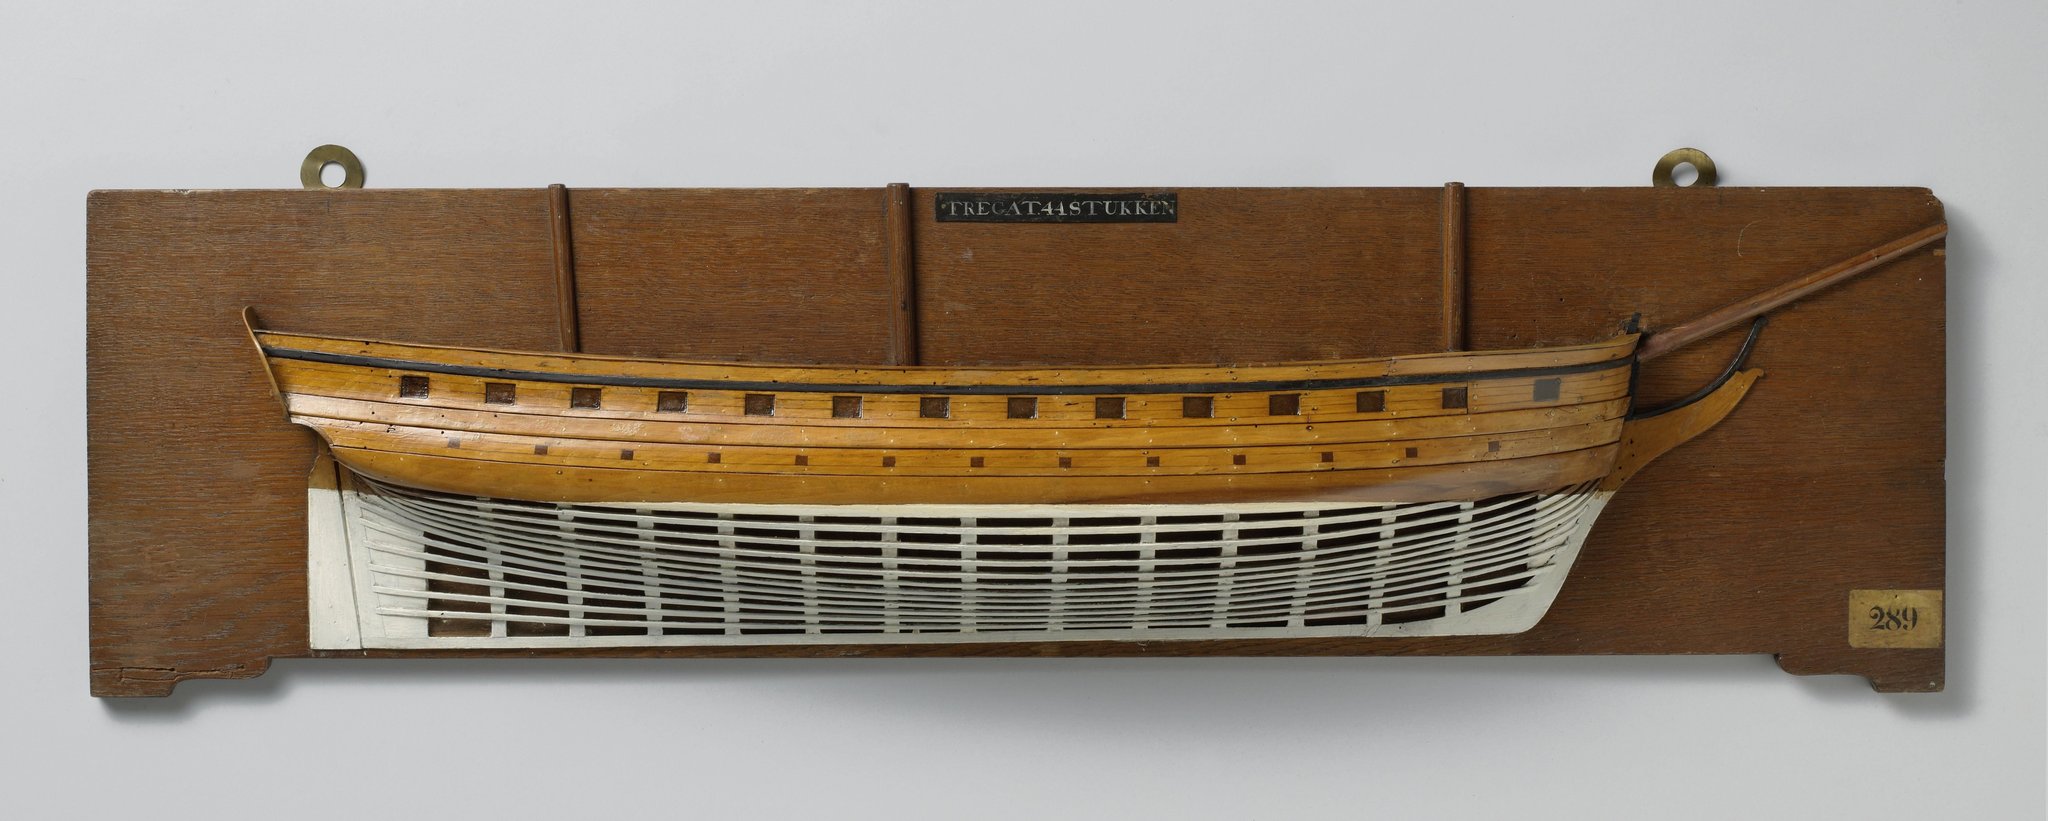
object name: ship model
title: Half Model of a 44-Gun Frigate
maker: Anonymous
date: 1780-1825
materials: copper, wood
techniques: polychromy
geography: netherlands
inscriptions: label, bottom right: ‘289’ former inventory label, inscription, top centre, on a square black metal label: ‘FREGAT. 44 STUKKEN’